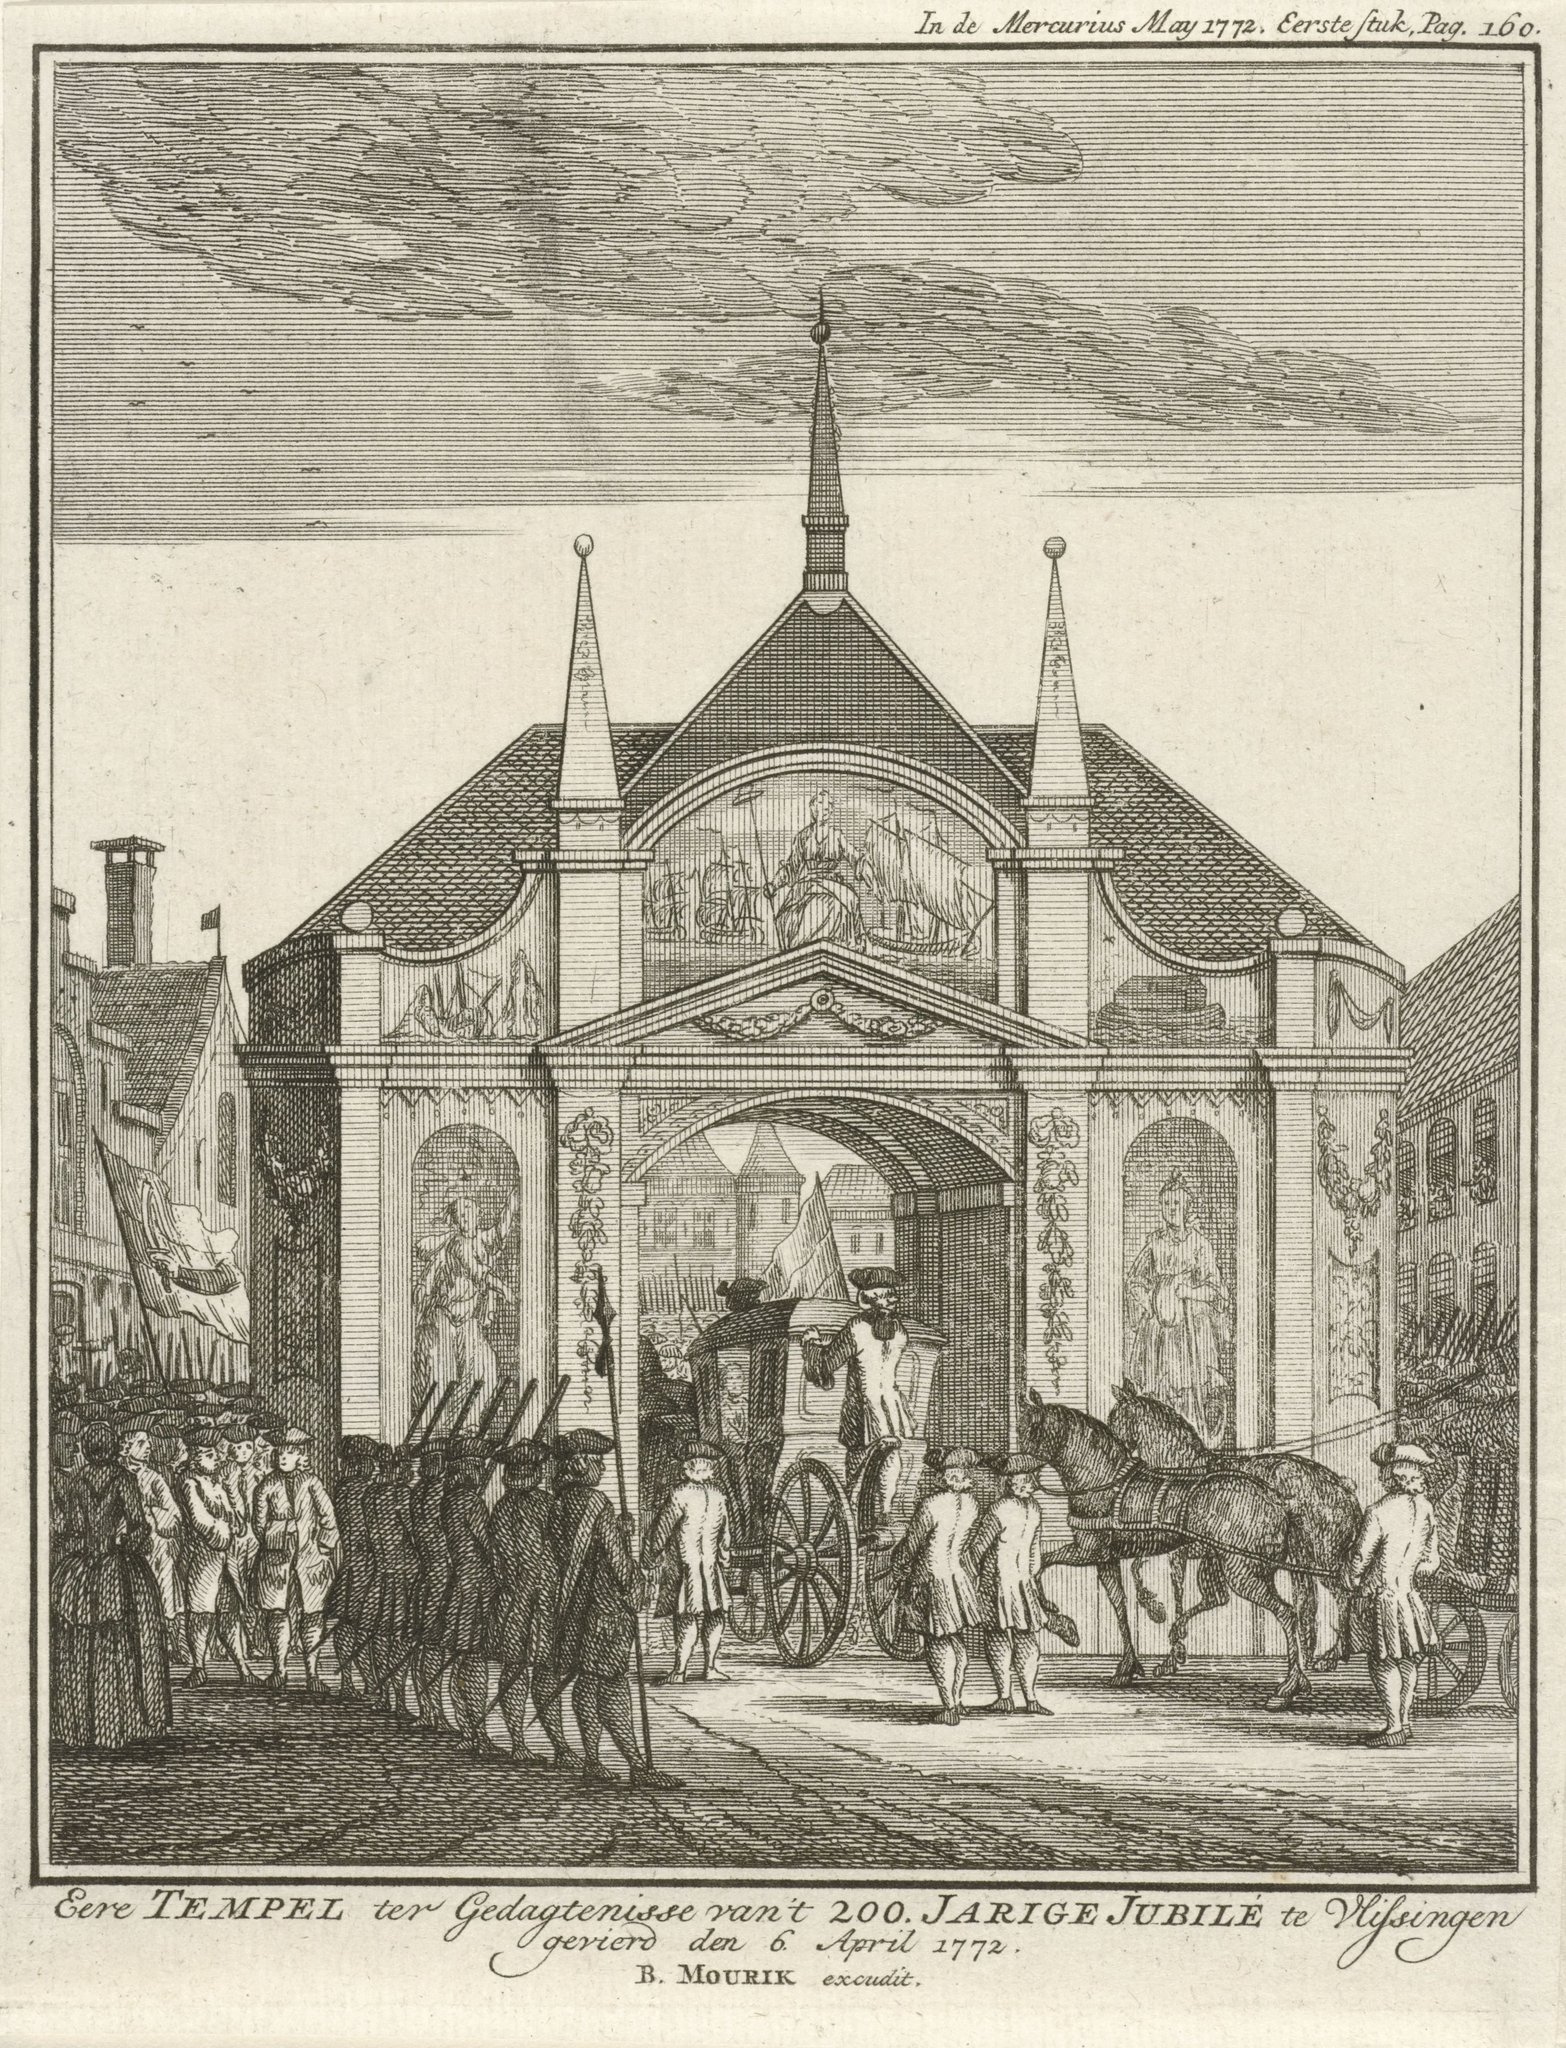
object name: print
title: Triomfpoort ter ere van 200 jaar vrijheid in Vlissingen, 1772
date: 1772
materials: paper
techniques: engraving, etching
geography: northern netherlands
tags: triumphal arch, flushing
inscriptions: collector's mark: Lugt 2228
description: Triomfpoort opgericht in de stad bij de viering van 200 jaar vrijheid in Vlissingen, 6 april 1772. Rijtuigen rijden door de erepoort of tempel.